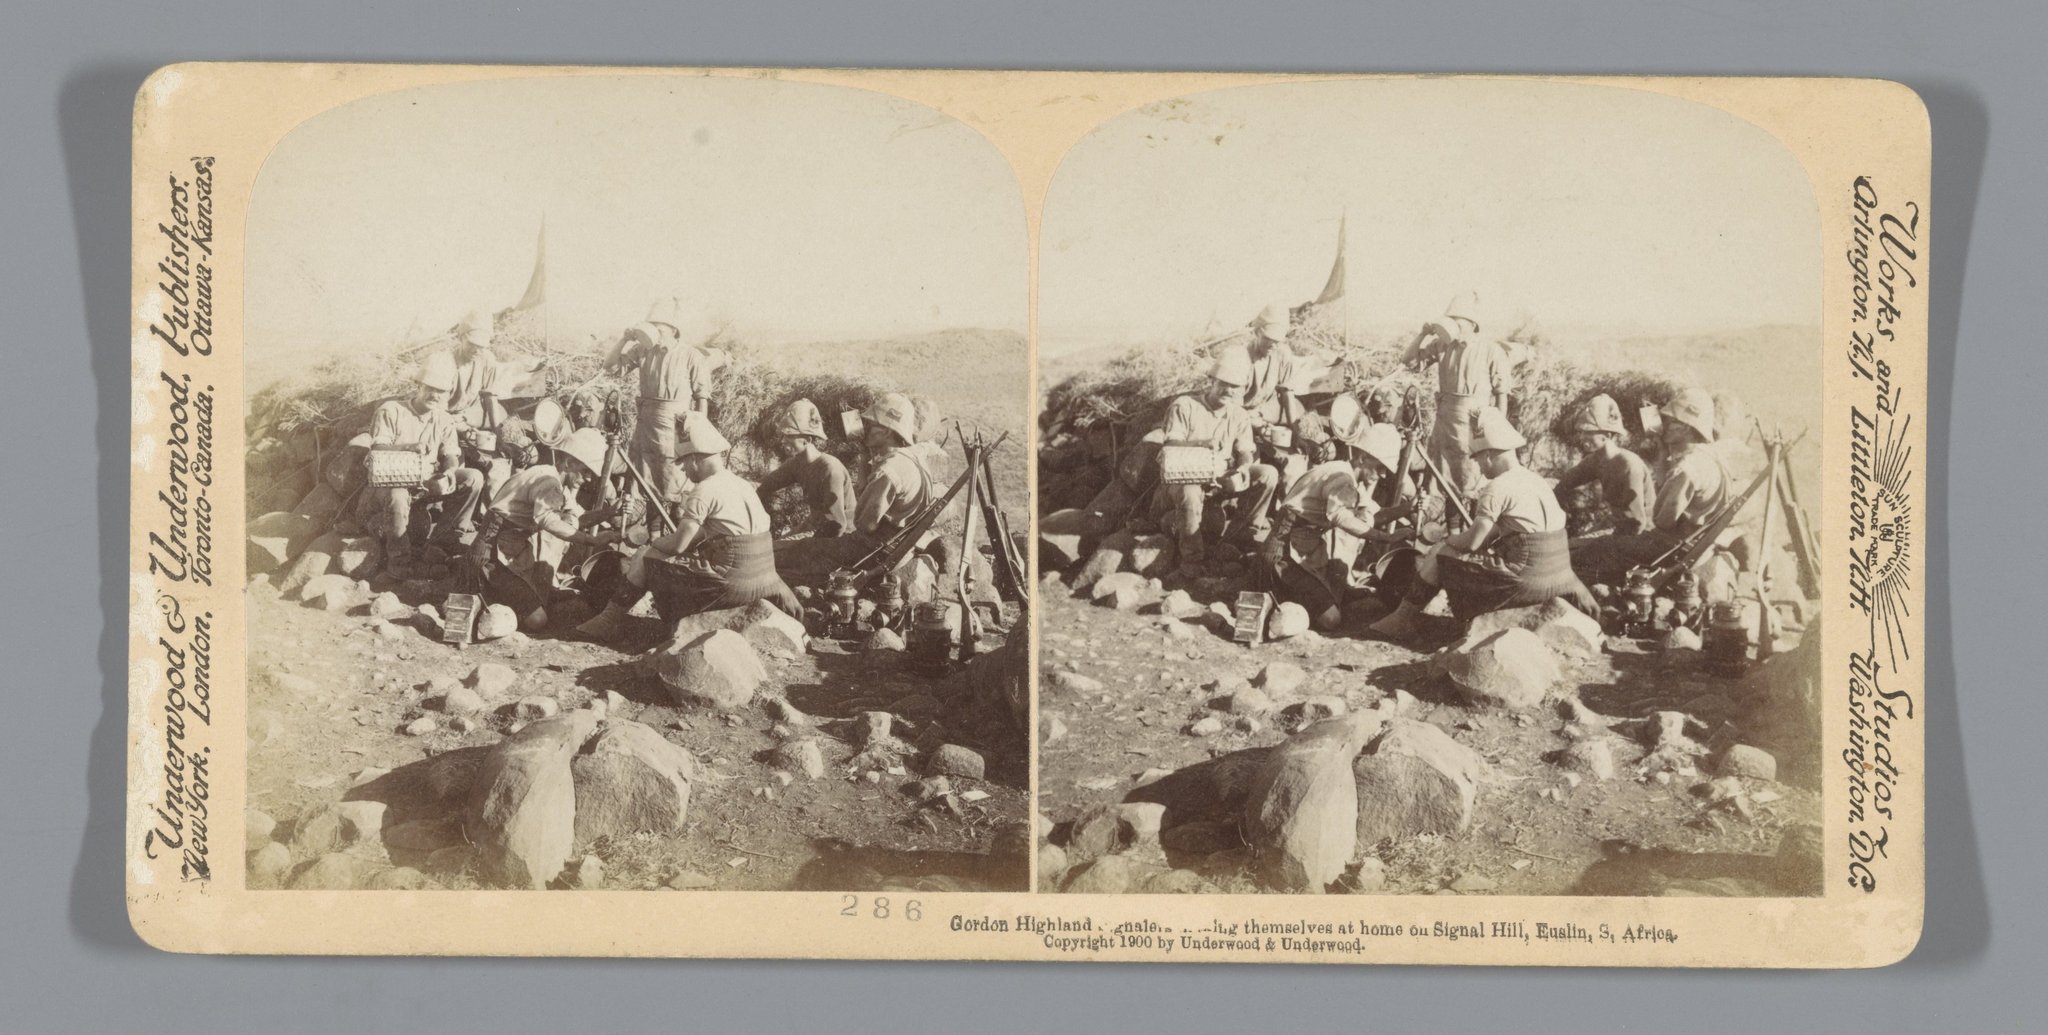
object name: stereograph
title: Militairen van de Gordon Highlanders installeren zichzelf op een heuvel, Zuid-Afrika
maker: Anonymous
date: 1900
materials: cardboard, paper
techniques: albumen print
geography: south africa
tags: the soldier off duty, shelter ~ military service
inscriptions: inscription, number: ‘286’, copyright notice: ‘Copyright 1900 by Underwood & Underwood.’, inscription: ‘Works and Studios ~/ Arlington, N.J. Littleton, N.H. Washington, D.C.’